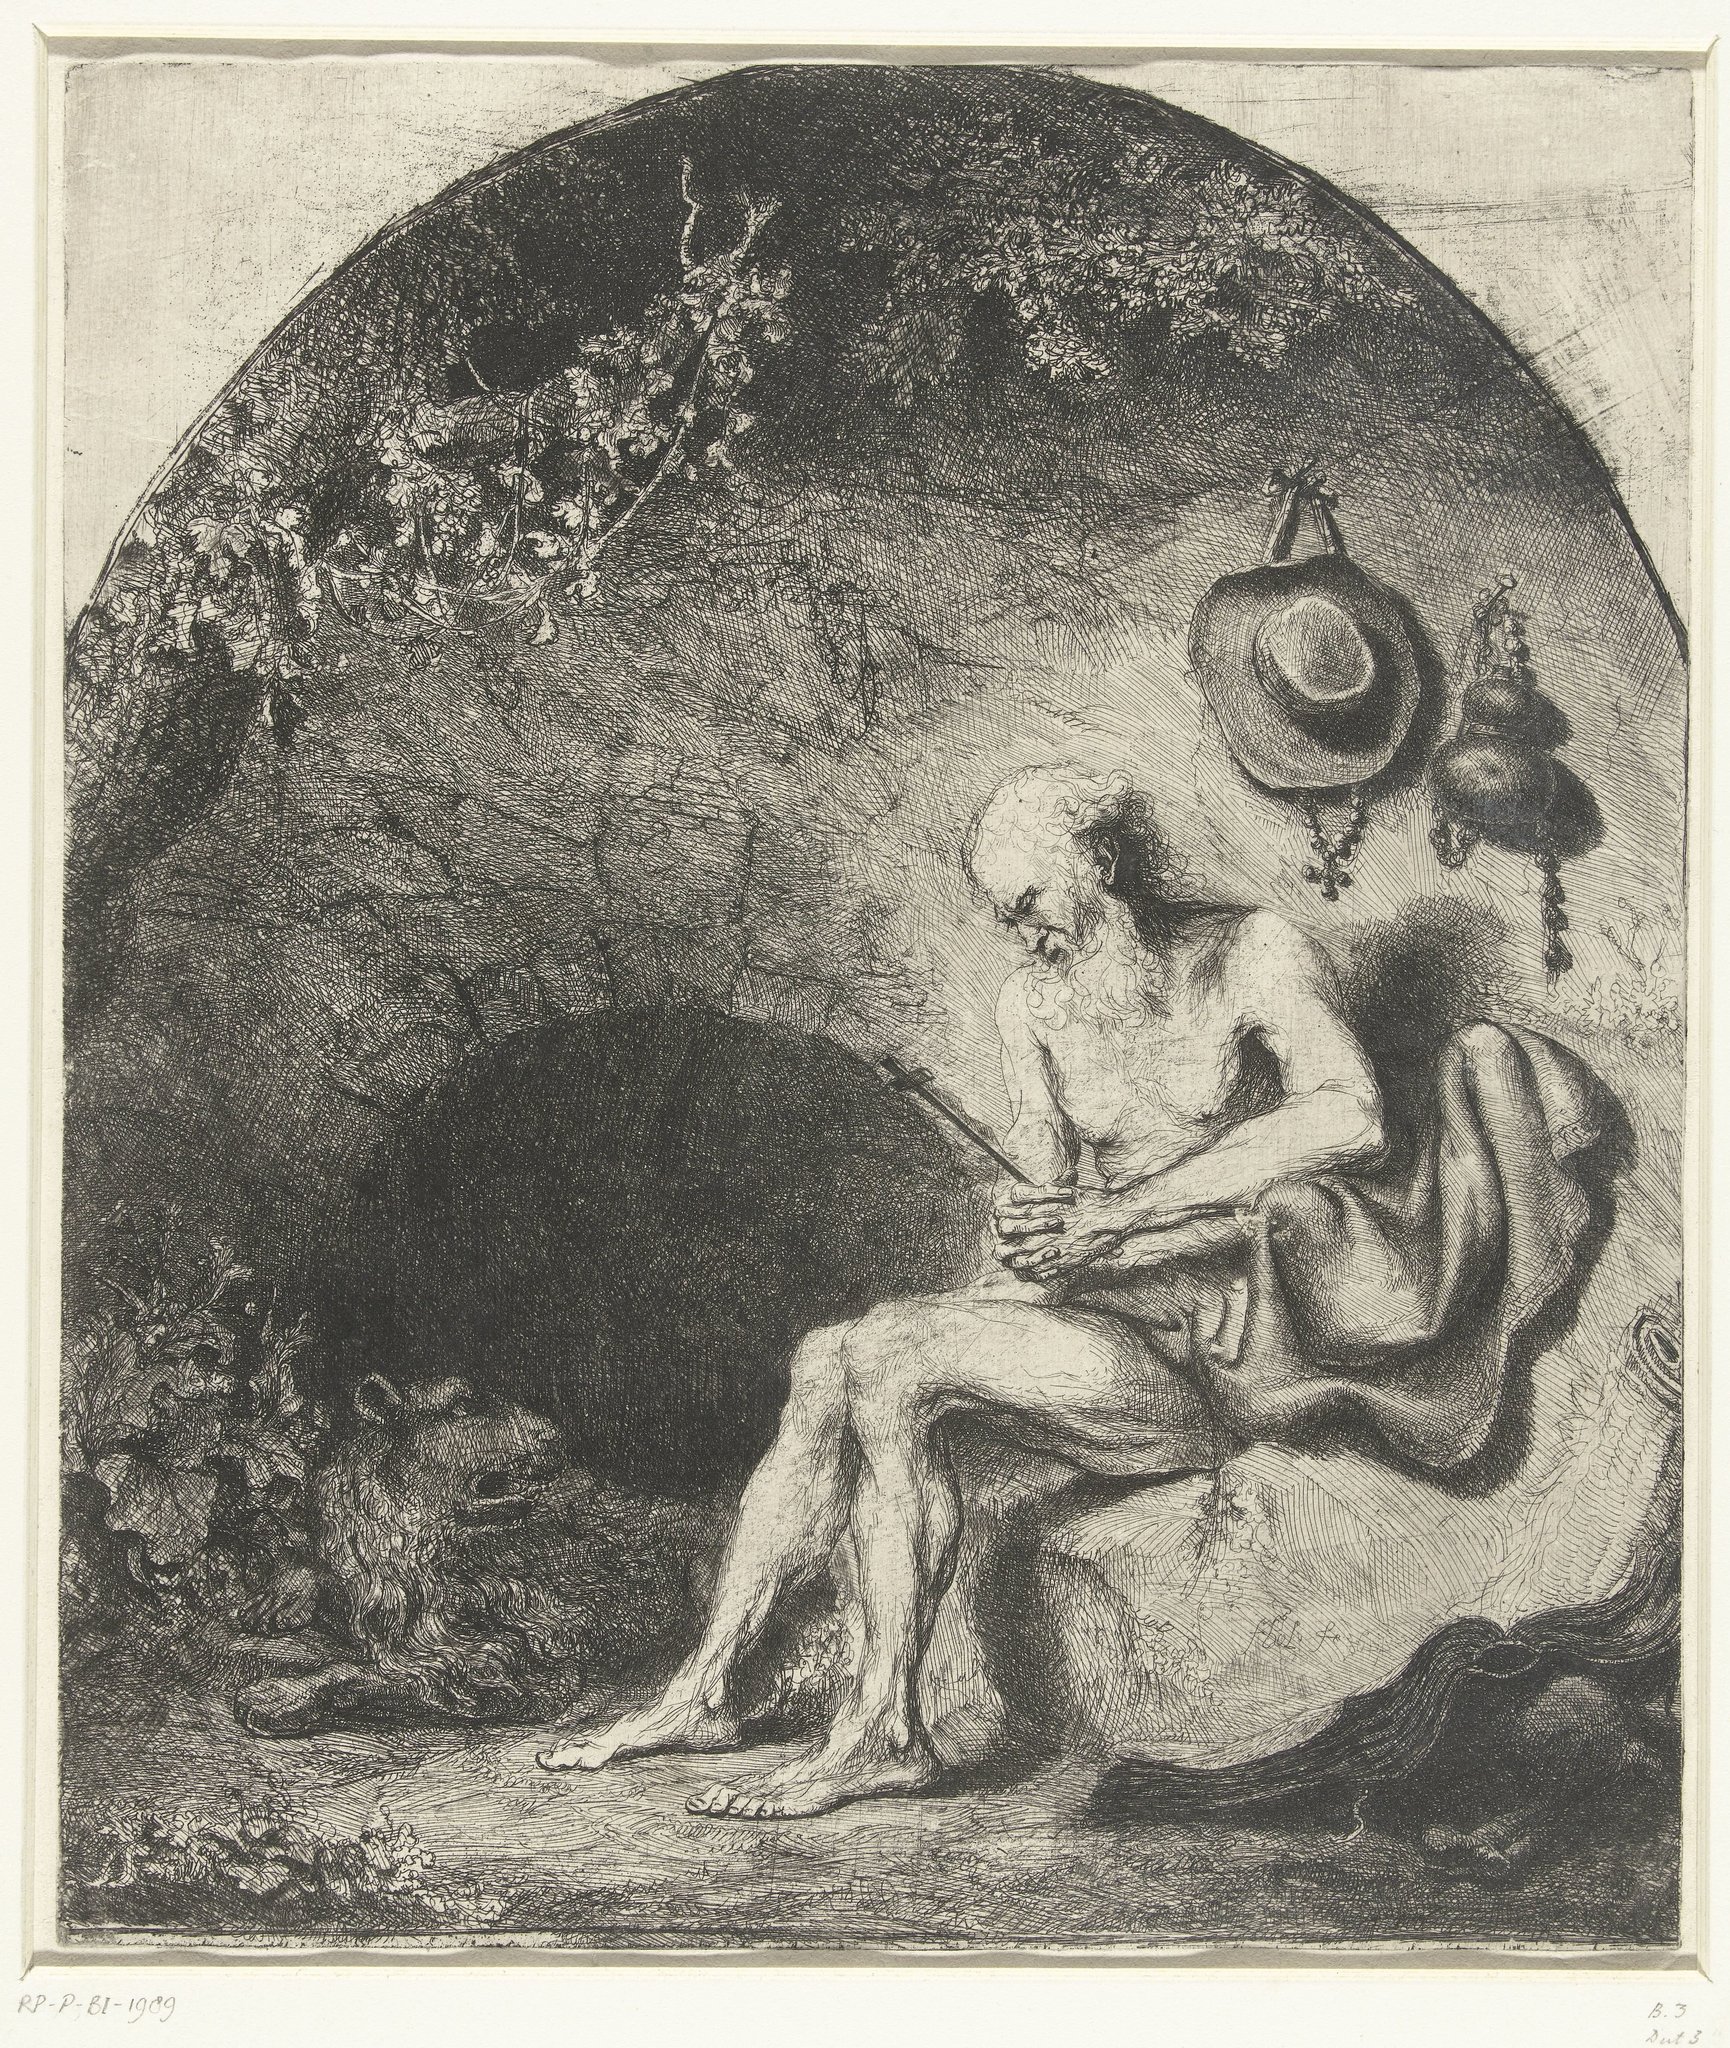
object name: print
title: Hieronymus in een grot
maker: ferdinand bol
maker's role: draughtsman, painter, print maker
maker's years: 1616-1680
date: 1644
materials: paper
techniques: etching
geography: netherlands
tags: the monk and hermit jerome (hieronymus); possible attributes: book, cardinal's hat, crucifix, hour-glass, lion, skull, stone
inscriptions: collector's mark: Lugt 240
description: De heilige Hieronymus als kluizenaar zittend in een grot met crucifix in zijn handen, aan zijn voeten ligt de leeuw.